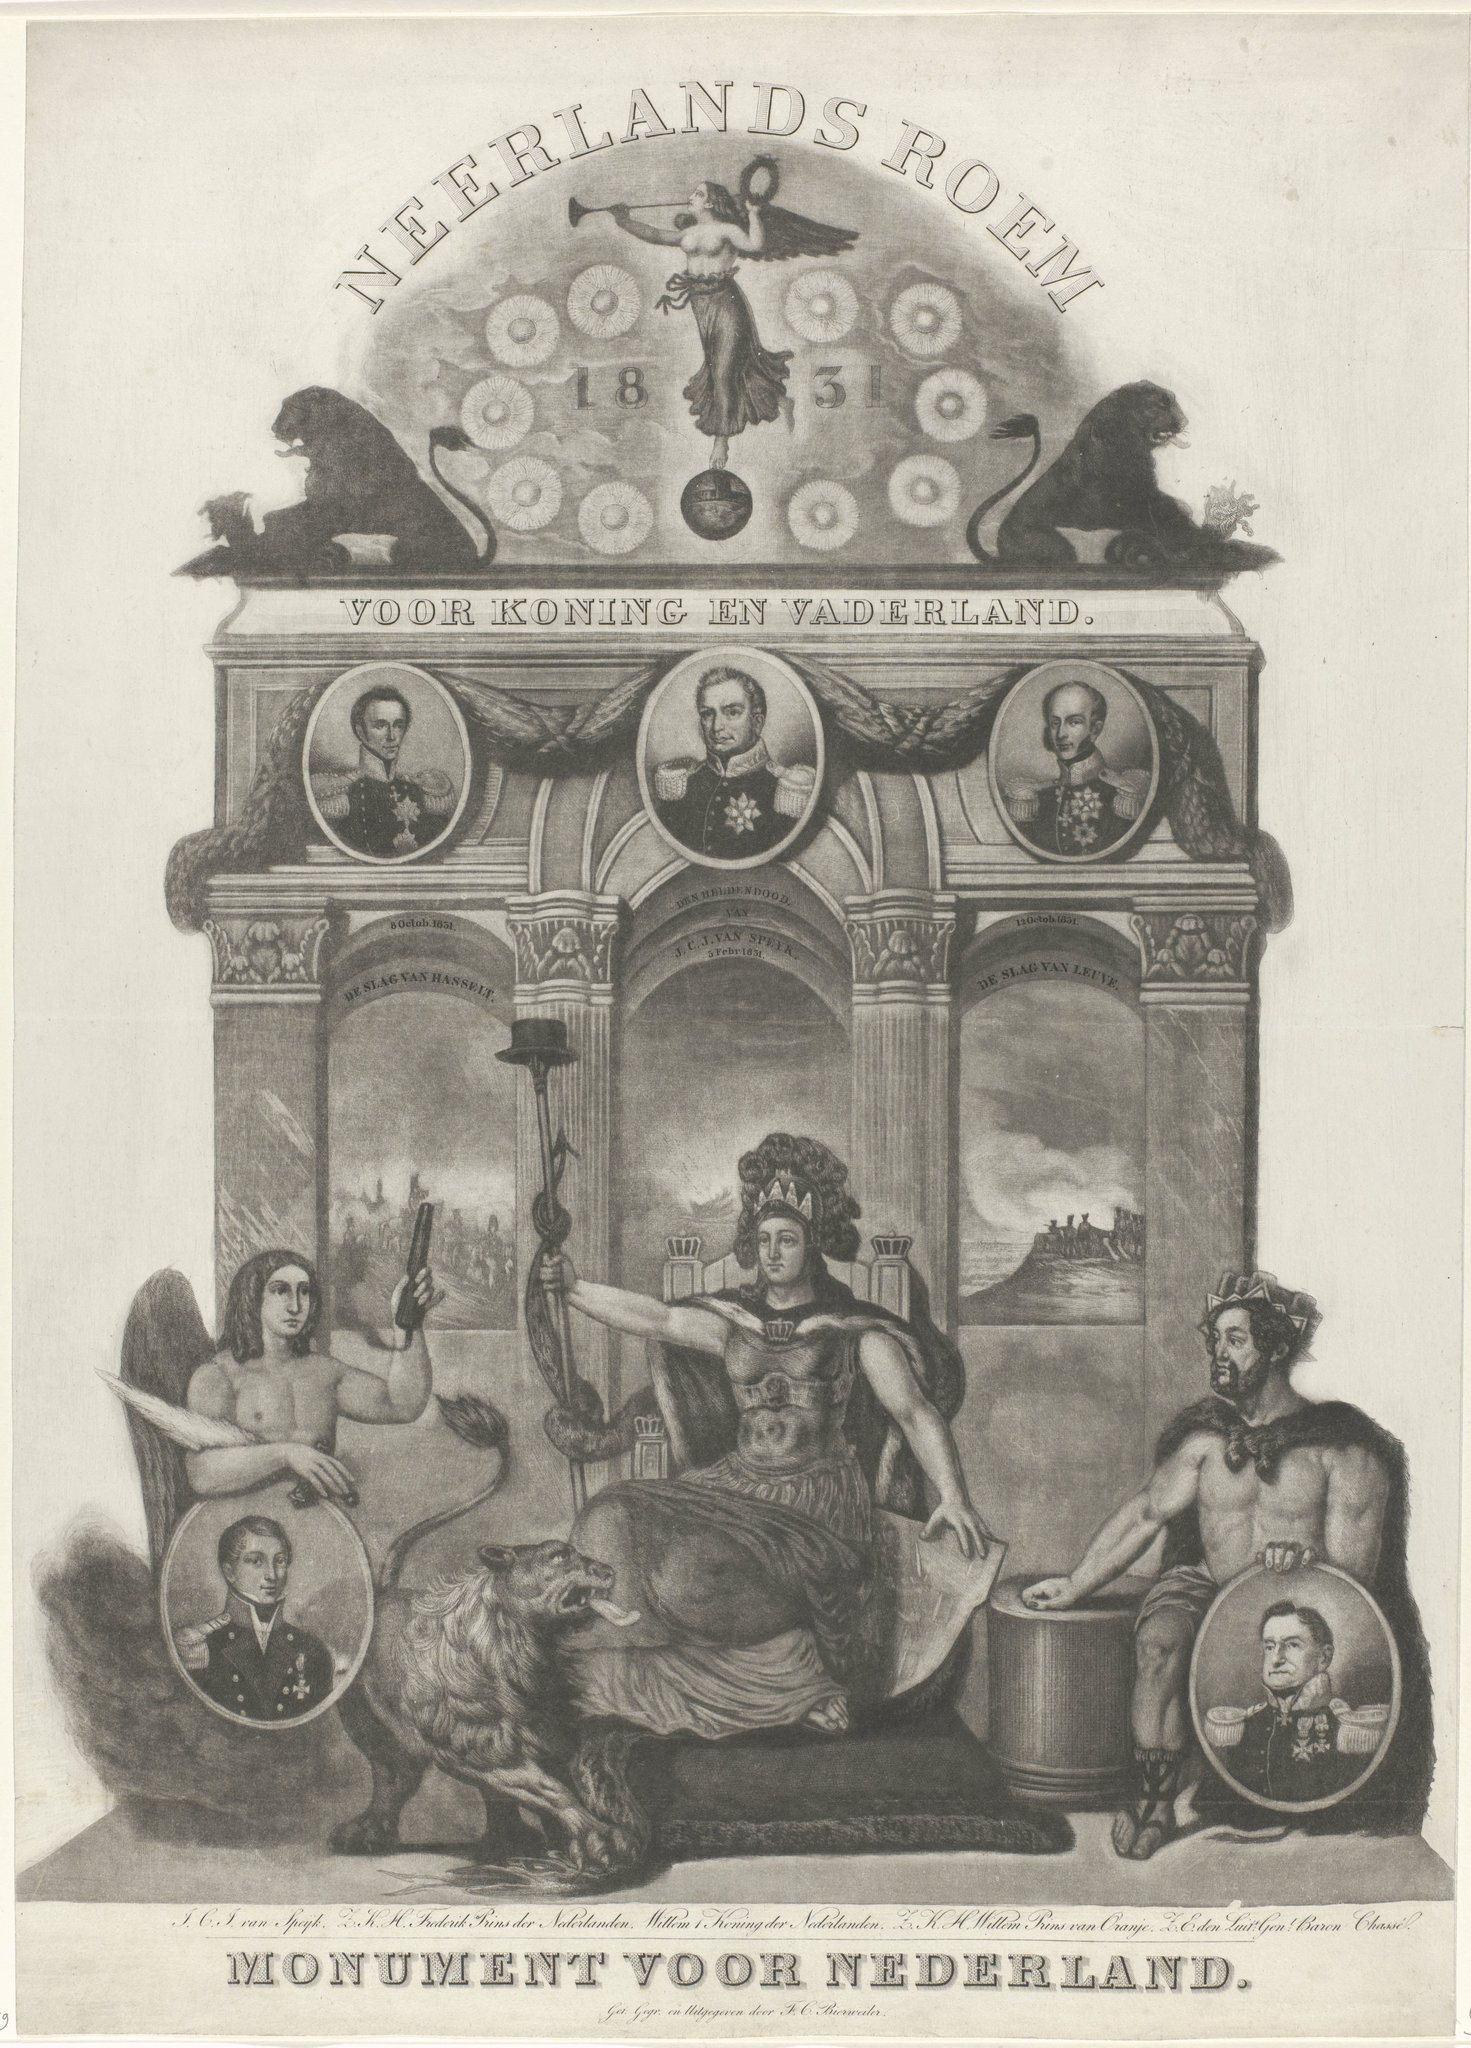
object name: print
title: Monument voor Nederland. Neerlands Roem voor Koning en Vaderland. 1831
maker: frederik christiaan bierweiler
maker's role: print maker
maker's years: 1783-1831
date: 1832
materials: paper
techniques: aquatint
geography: netherlands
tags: amsterdam, antwerp, jan van speyk, david hendrik baron chassé, the hague, william i of the netherlands, william ii of the netherlands, berlin, frederik (prins der nederlanden), personifications of countries, nations, states, districts, etc., fame; 'fama', 'fama buona', 'fama chiara' (ripa), battle (+ land forces), netherlands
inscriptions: collector's mark: Lugt 2228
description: Allegorisch monument ter ere van de roemrijke overwinningen van het Nederlandse leger in het jaar 1831. Centraal voor het monument zit de Nederlandse Maagd begeleid door de Nederlandse Leeuw, zij vertreden de slang van de Belgische rebellie. Links een engel met het portret van Jan van Speyk, rechts Hercules met portret van generaal Chassé. Op het monument in de drie togen voorstellingen van de slag bij Hasselt (8 augustus), de zelfopoffering door Van Speyk (5 februari) en de slag bij Leuven (12 augustus). Hierboven portretten van koning Willem I en zijn twee zoons. Helemaal boven de Faam met bazuin en het jaartal 1831.